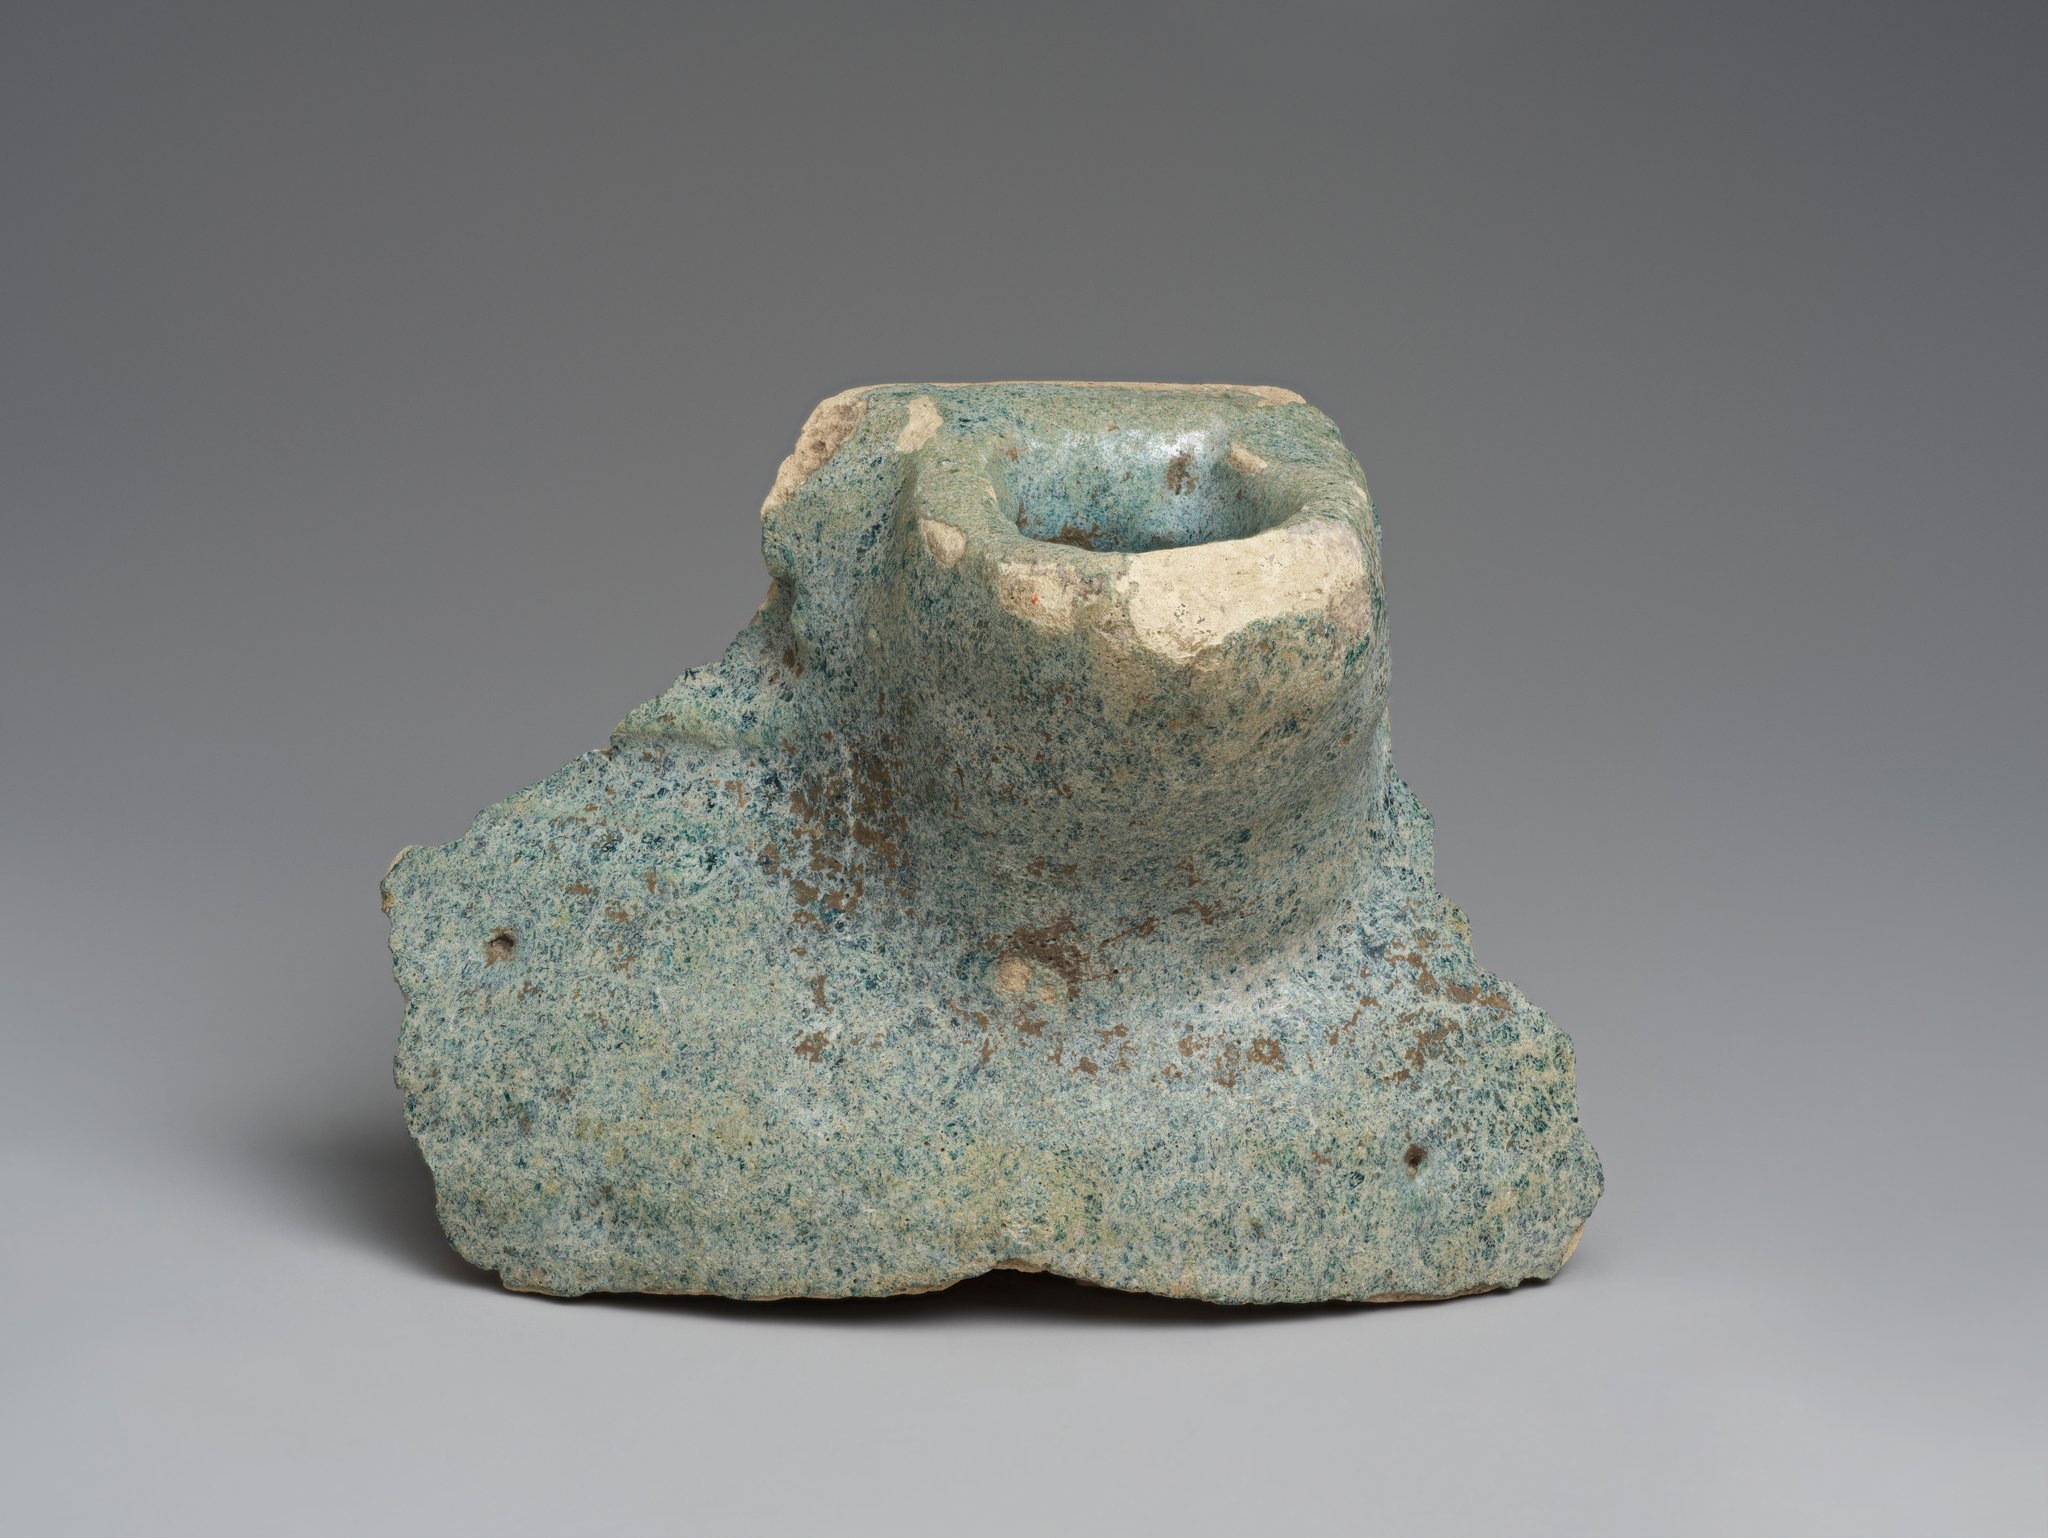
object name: jar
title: Jar sherd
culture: sasanian or islamic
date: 601-800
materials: ceramic, glaze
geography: mesopotamia